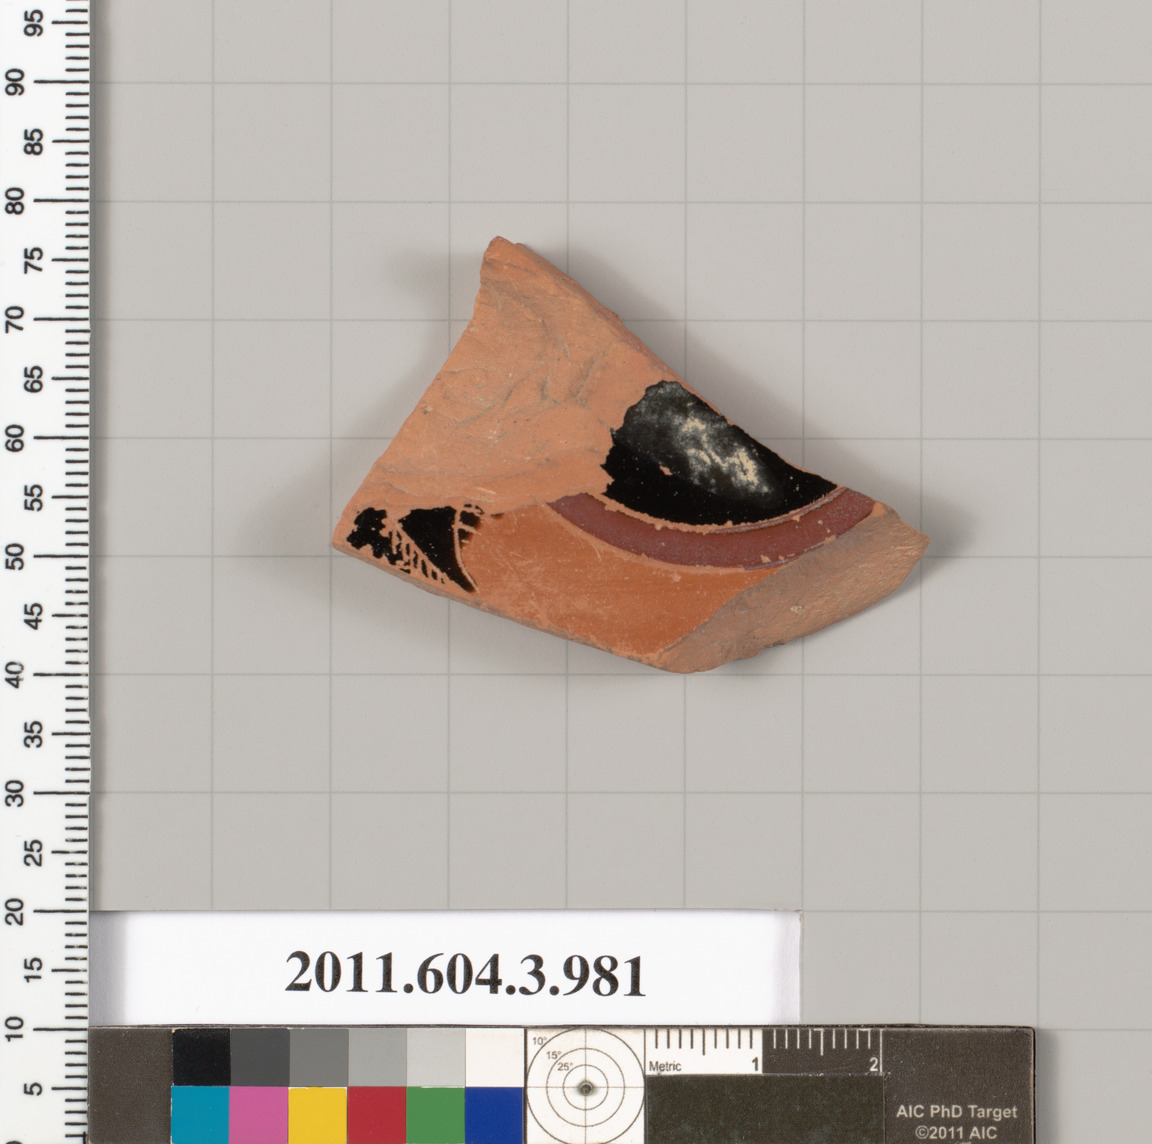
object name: lekanis lid fragment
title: Terracotta fragment of a lekanis lid (covered dish)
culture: greek, attic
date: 575-551 BCE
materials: terracotta